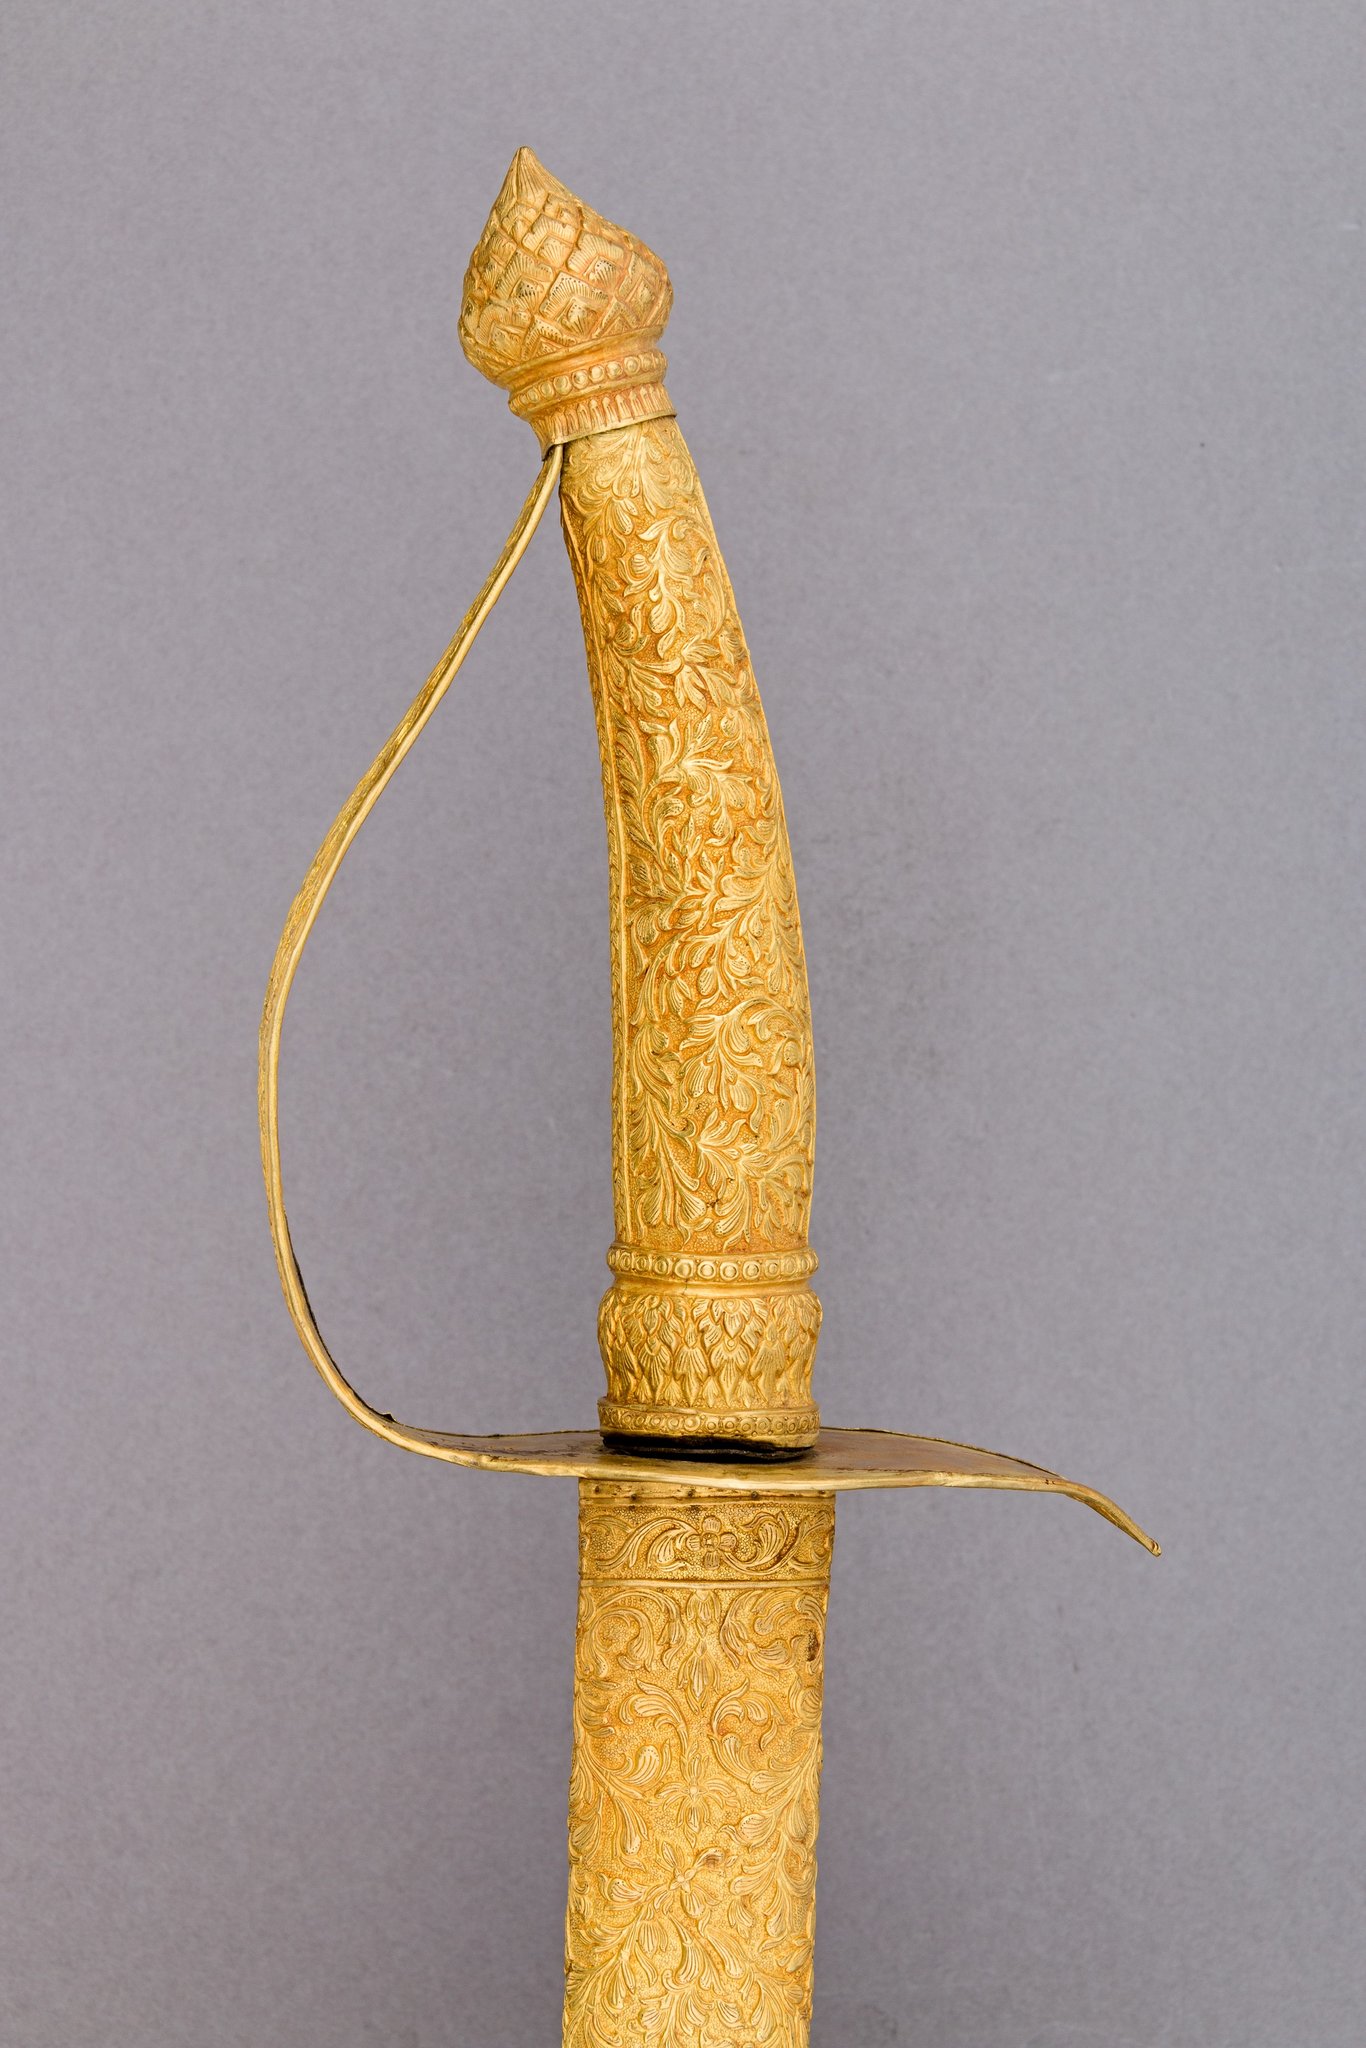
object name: sword with scabbard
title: Royal Presentation Sword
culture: thai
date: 1701-1800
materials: gold, steel, wood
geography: thailand